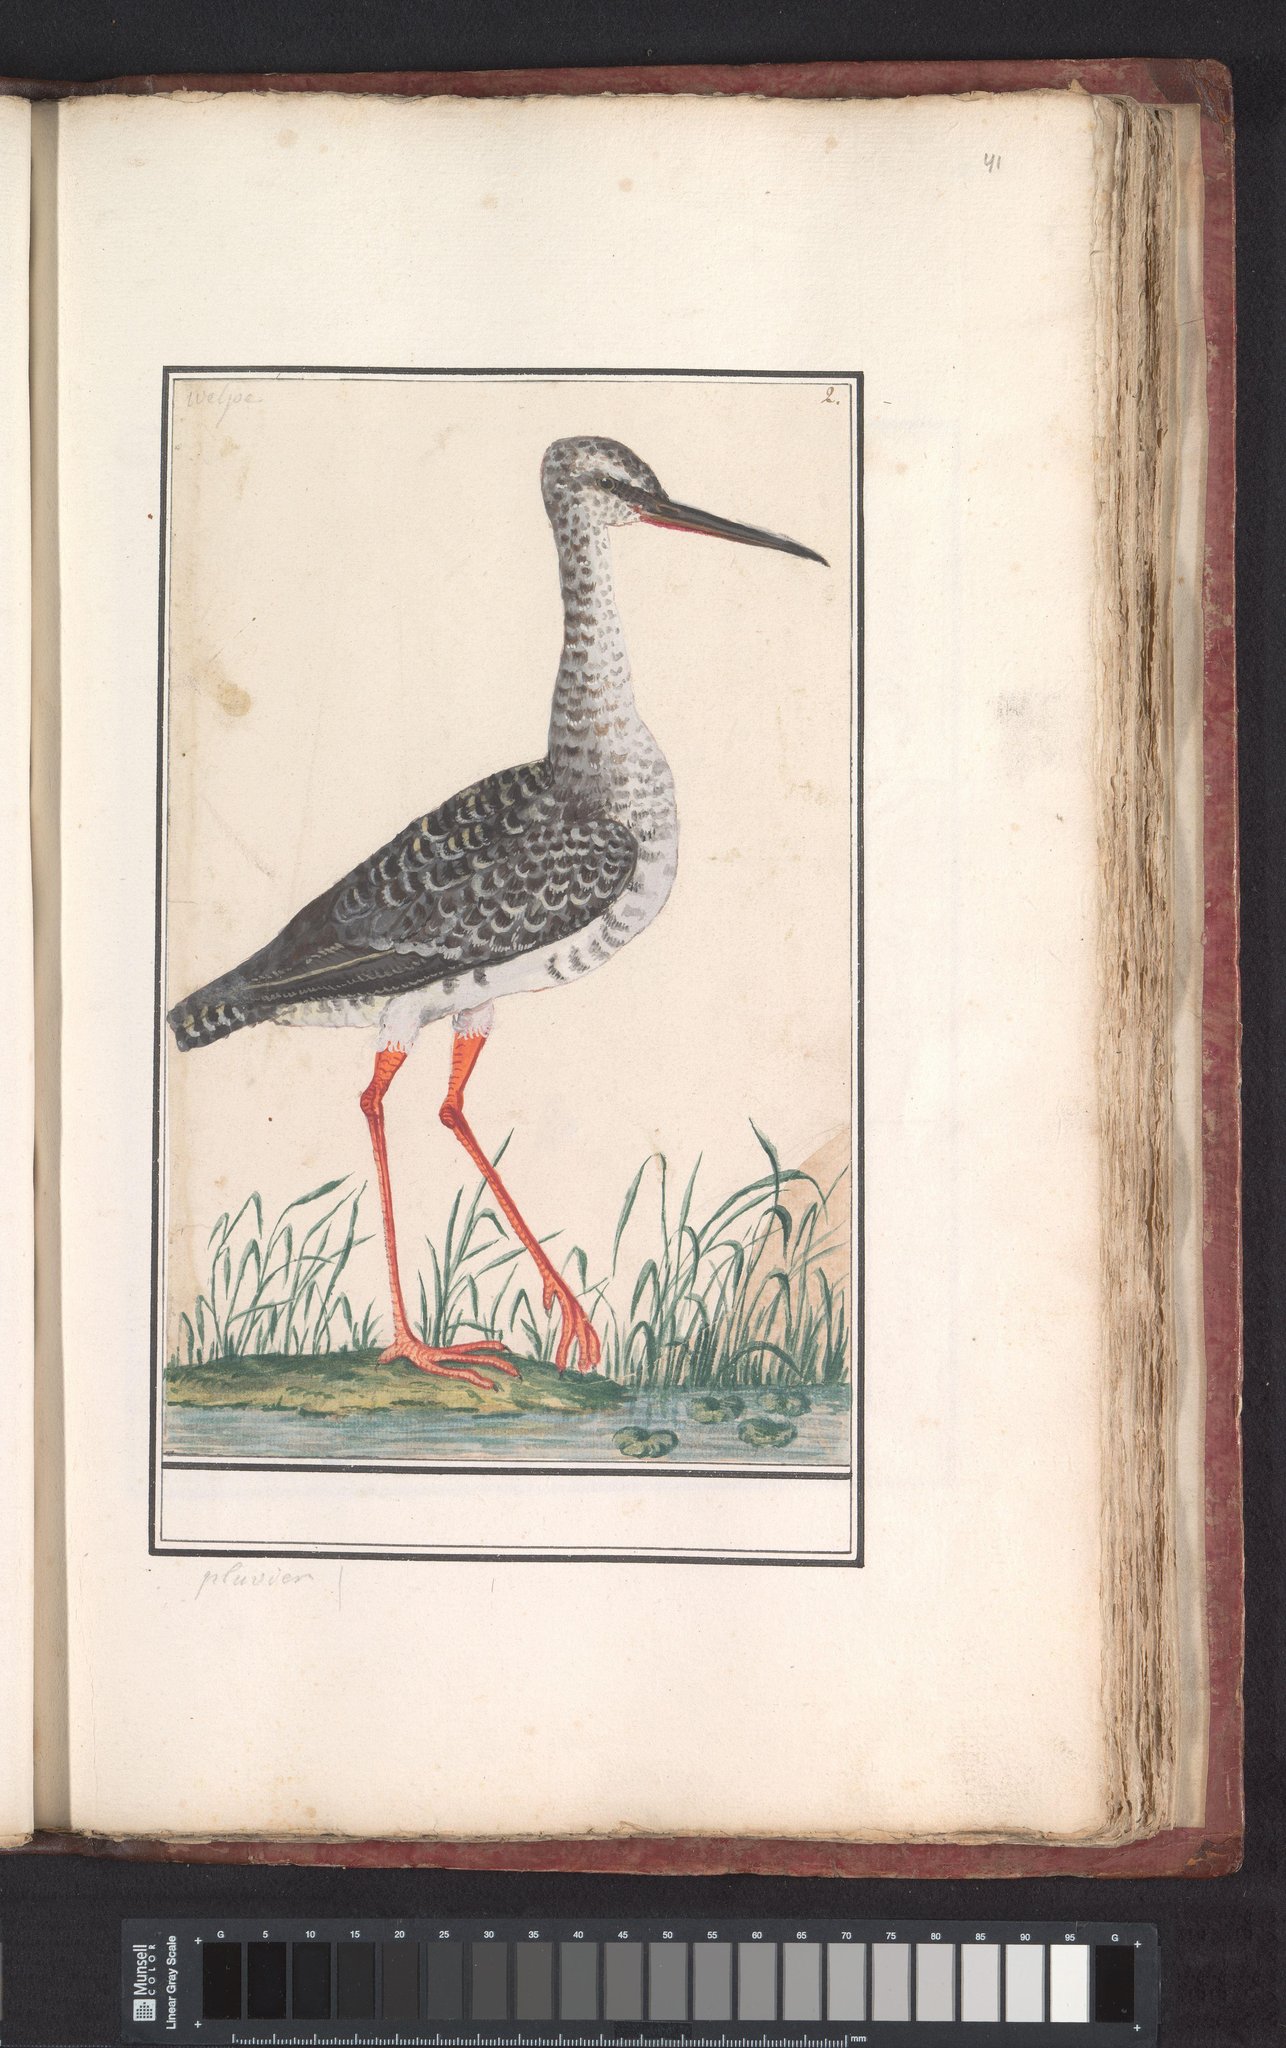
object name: drawing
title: Tureluur (Tringa totanus)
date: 1596-1610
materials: chalk, paint, paper, pencil, watercolor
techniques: brush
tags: shore-birds and wading-birds: redshank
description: Tureluur. Genummerd rechtsboven: 2. Onderdeel van het derde album met tekeningen van vogels. Vijfde van twaalf albums met tekeningen van dieren, vogels en planten bekend rond 1600, gemaakt in opdracht van keizer Rudolf II. Met toelichting in Nederlands, Latijn en Frans.